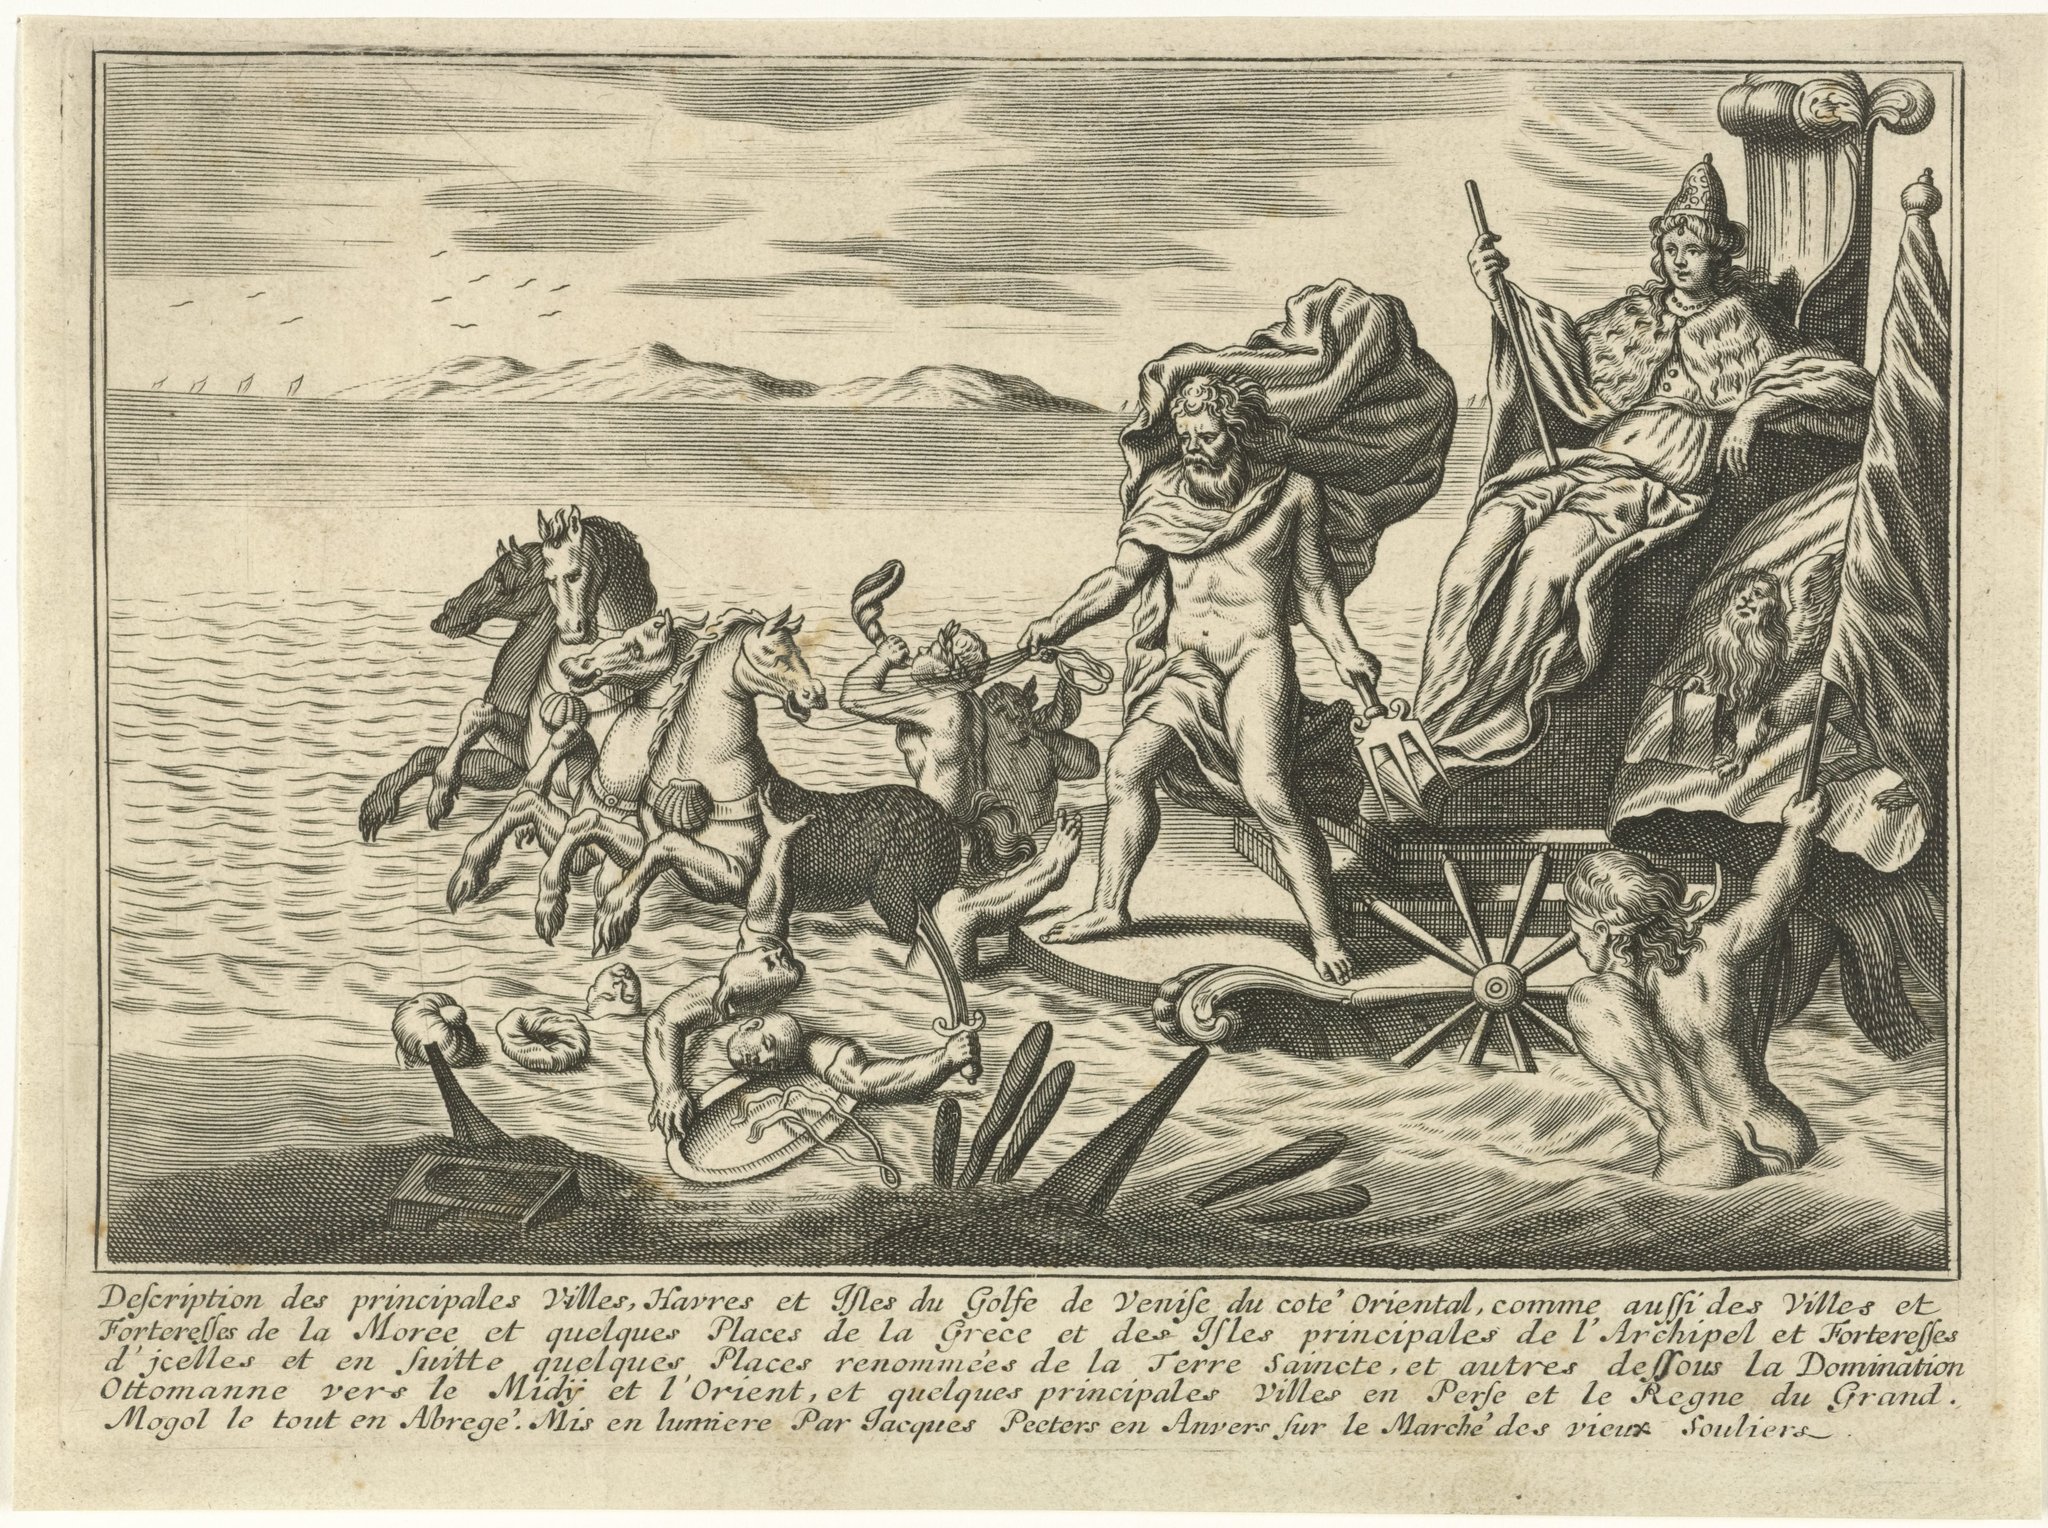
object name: titelblad, titelpagina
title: Neptunus en de Venetiaanse stedenmaagd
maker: jacob peeters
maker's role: print maker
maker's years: 1637-1695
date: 1690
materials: paper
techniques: engraving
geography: antwerp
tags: (story of) neptune (poseidon), personifications of countries, nations, states, districts, etc., venice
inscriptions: collector's mark: Lugt 2228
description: Titelpagina voor: Peeters, Jacob, Gaspard Bouttats, Description des principales villes, havres et isles du golfe de Venise du coté oriental: comme aussi des villes et forteresses de la Moree et quelques places de la Grece et des isles principales de l'Archipel ... et en suite quelques places renommées de la Terre Saincte, et autres dessous la domination ottomanne ... et quelques principales villes en Perse et le regne du Grand Mogol, le tout en abregé. Antwerpen: 1690.